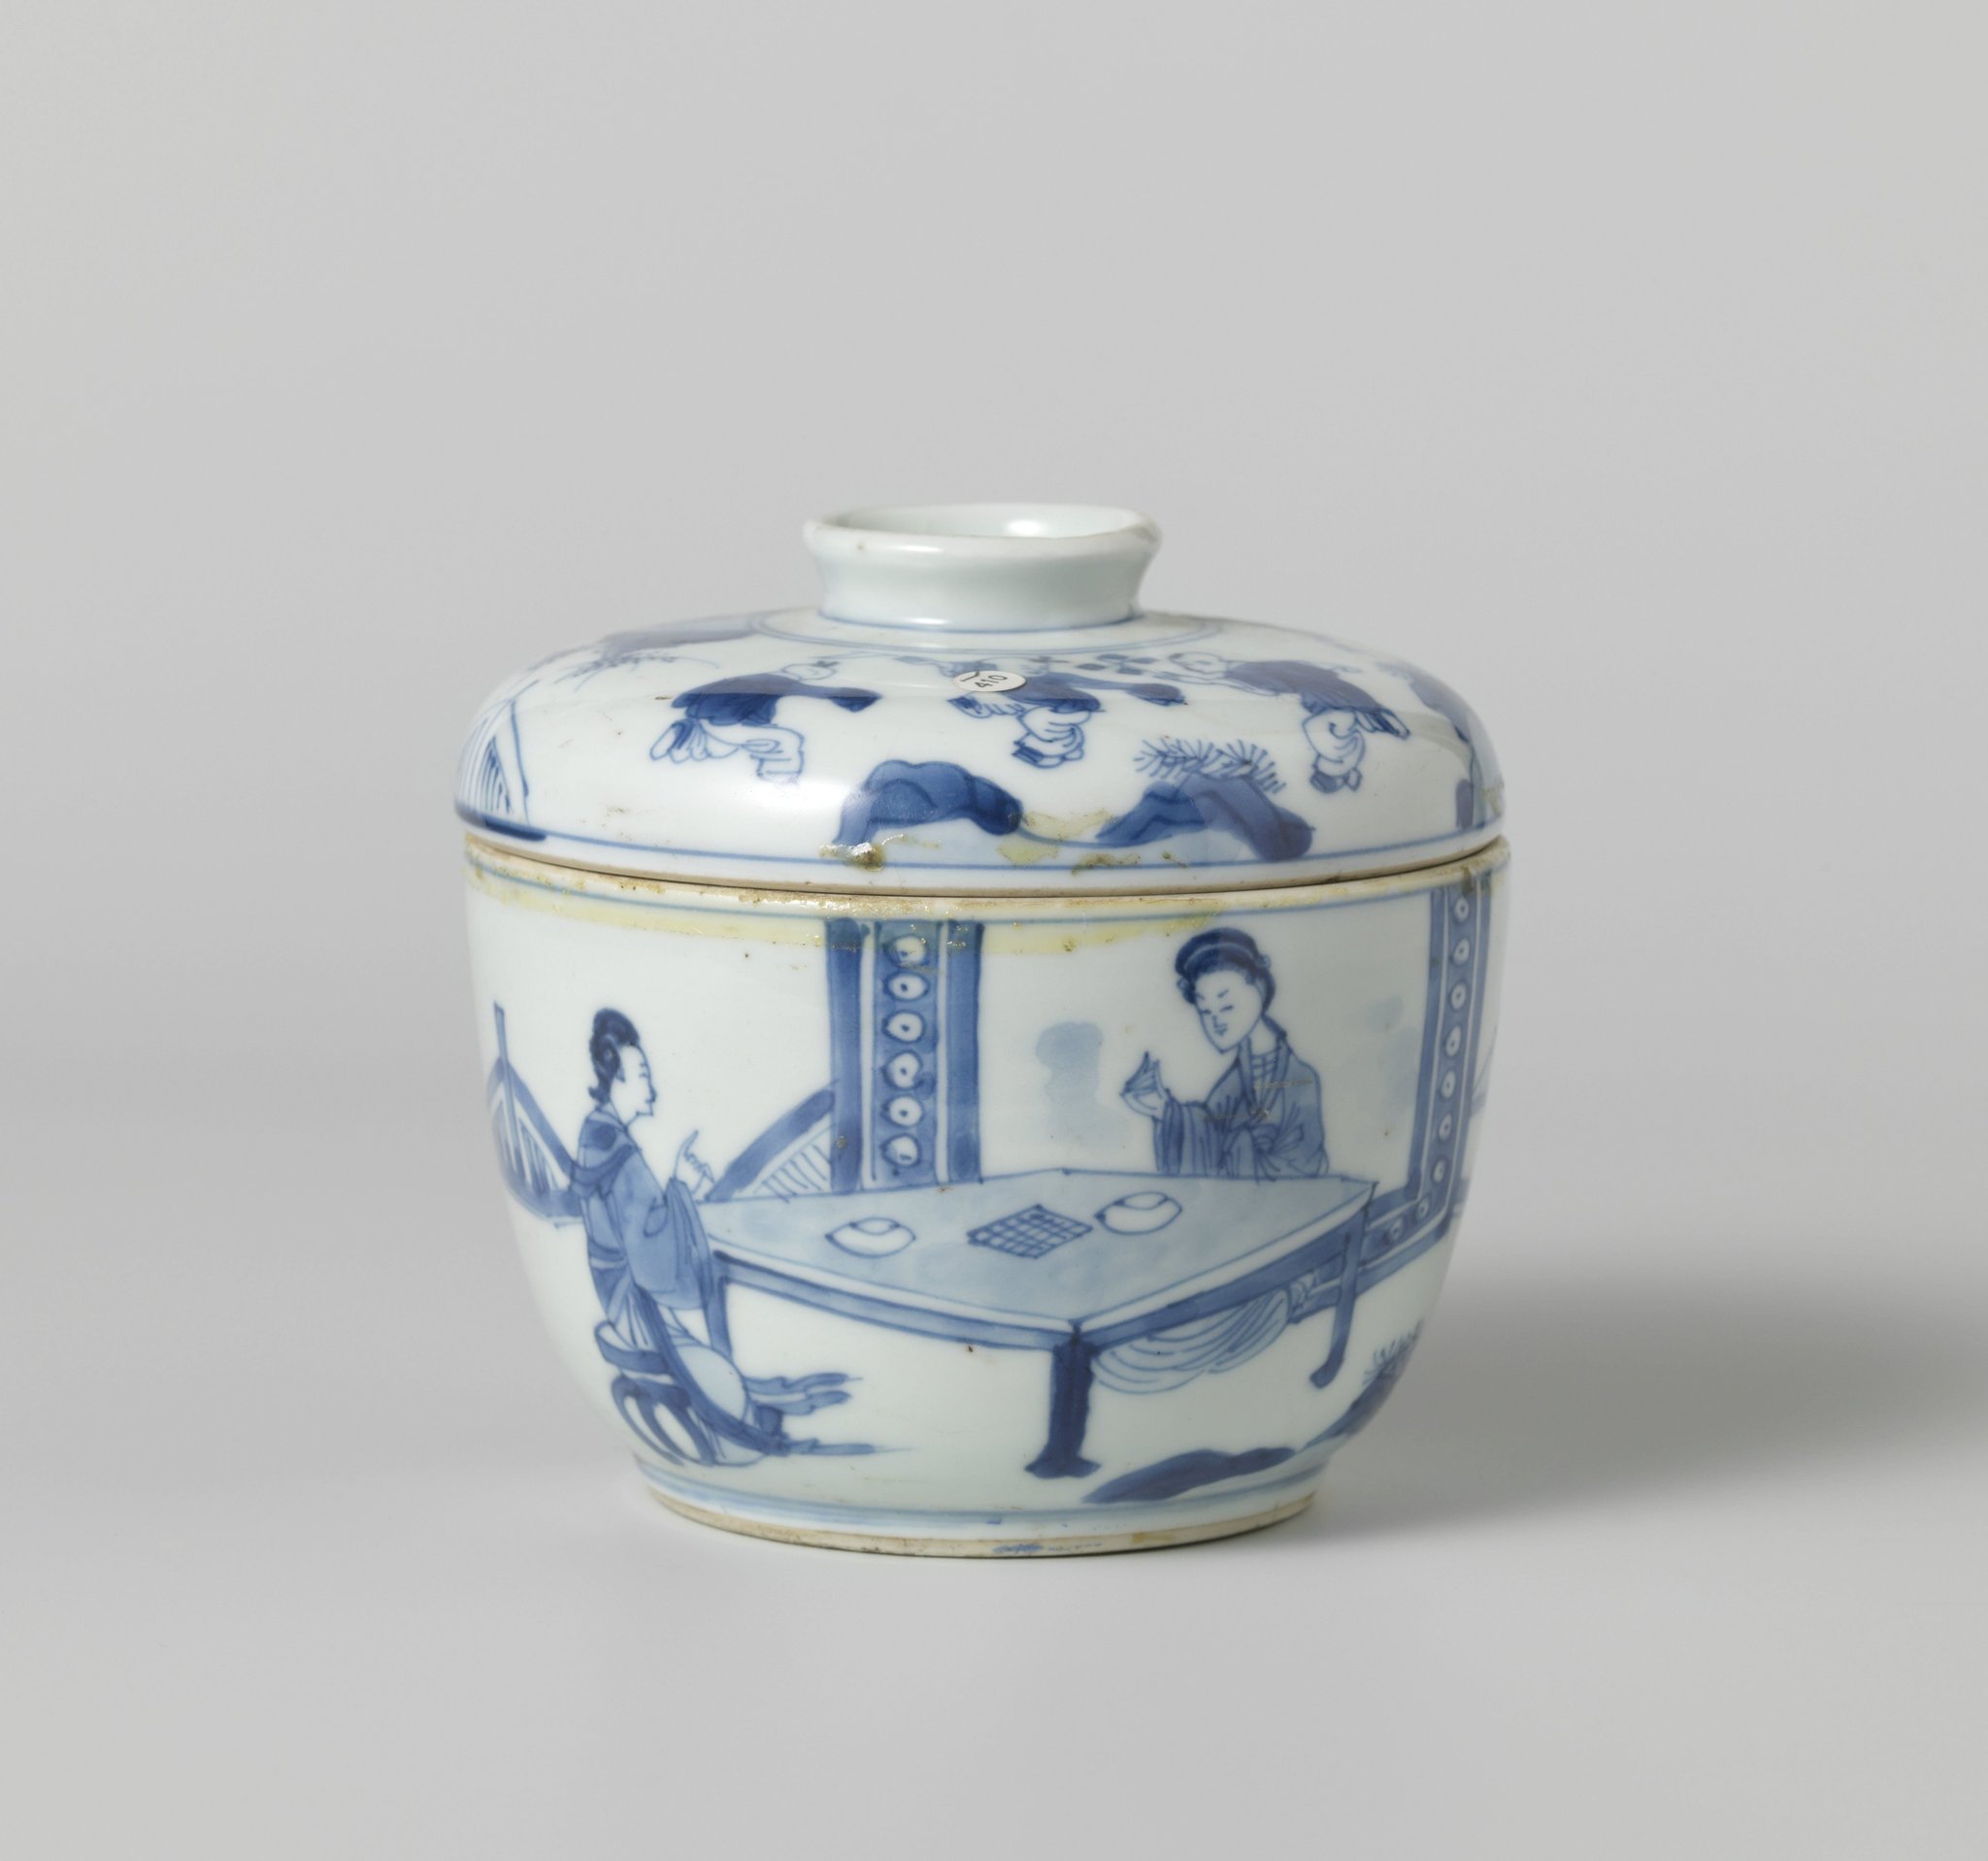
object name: covered jar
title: Covered jar with three women in a garden and playing boys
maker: Anonymous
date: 1680-1720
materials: cobalt, glaze, paint, porcelain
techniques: firing, turning, vitrification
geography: china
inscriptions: mark: ‘大 明 成 化 年 製’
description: Dekselpot van porselein, beschilderd in onderglazuur blauw. Op de pot een doorlopende scène met twee vrouwen aan een tafel 'go' spelend voor een scherm en een derde staand met een object in haar hand. Gemerkt op de onderzijde met het vier-karaktermerk van keizer Chenghua. Blauw-wit.